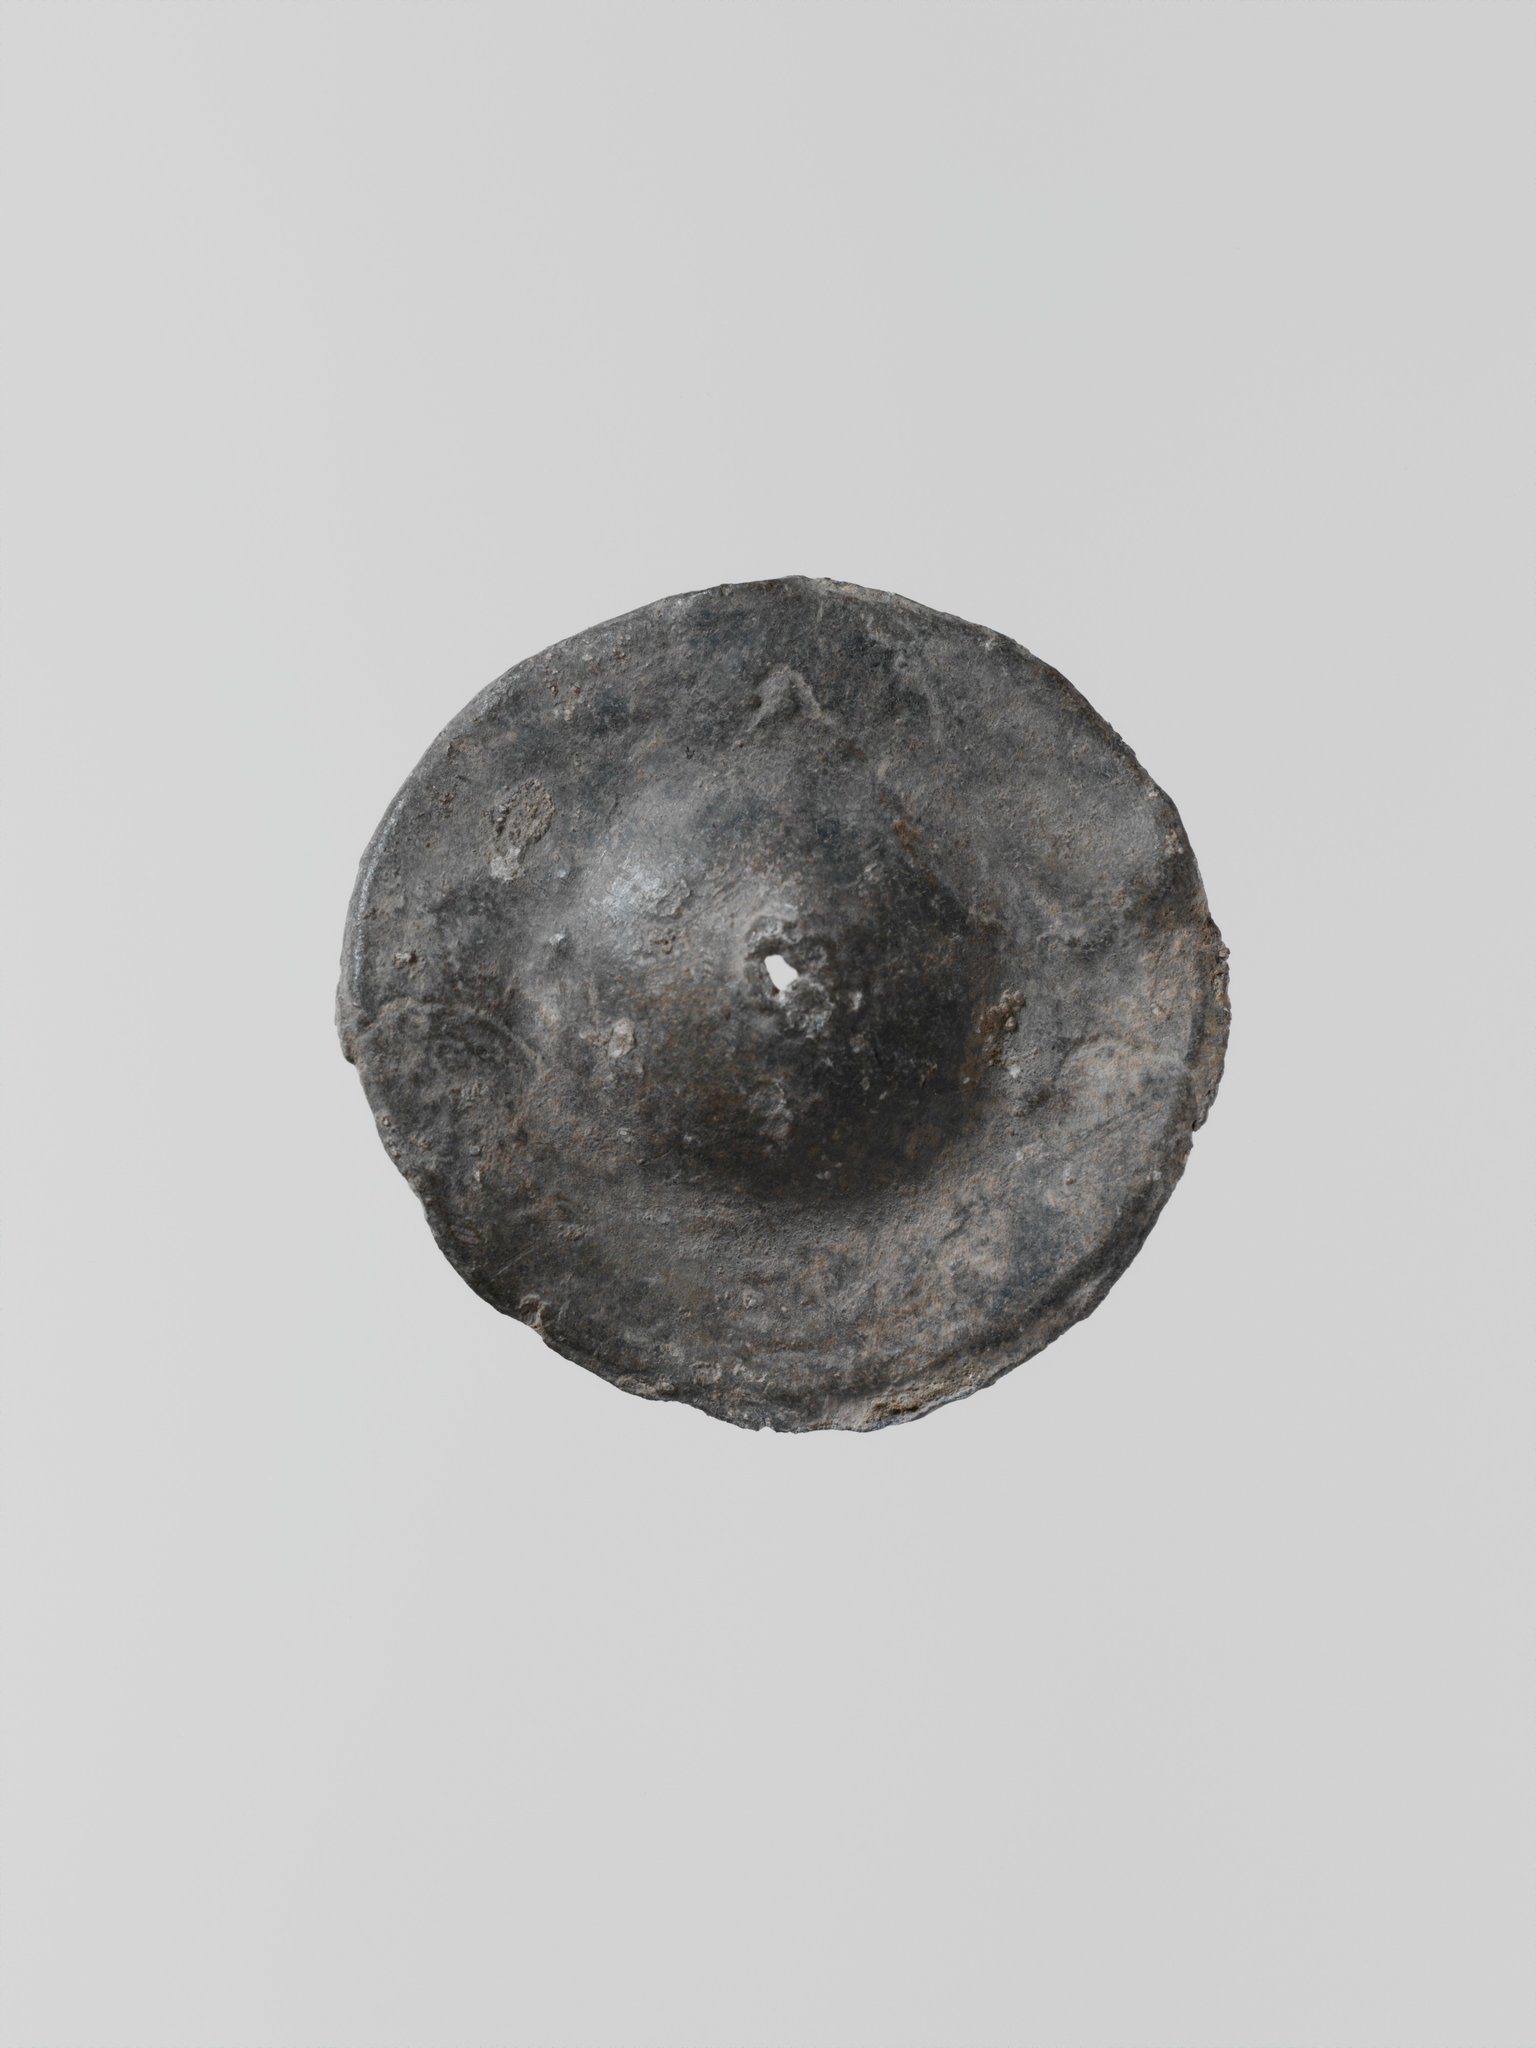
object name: disk, five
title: Lead disk with a hole in the center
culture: greek, laconian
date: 600-401 BCE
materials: lead